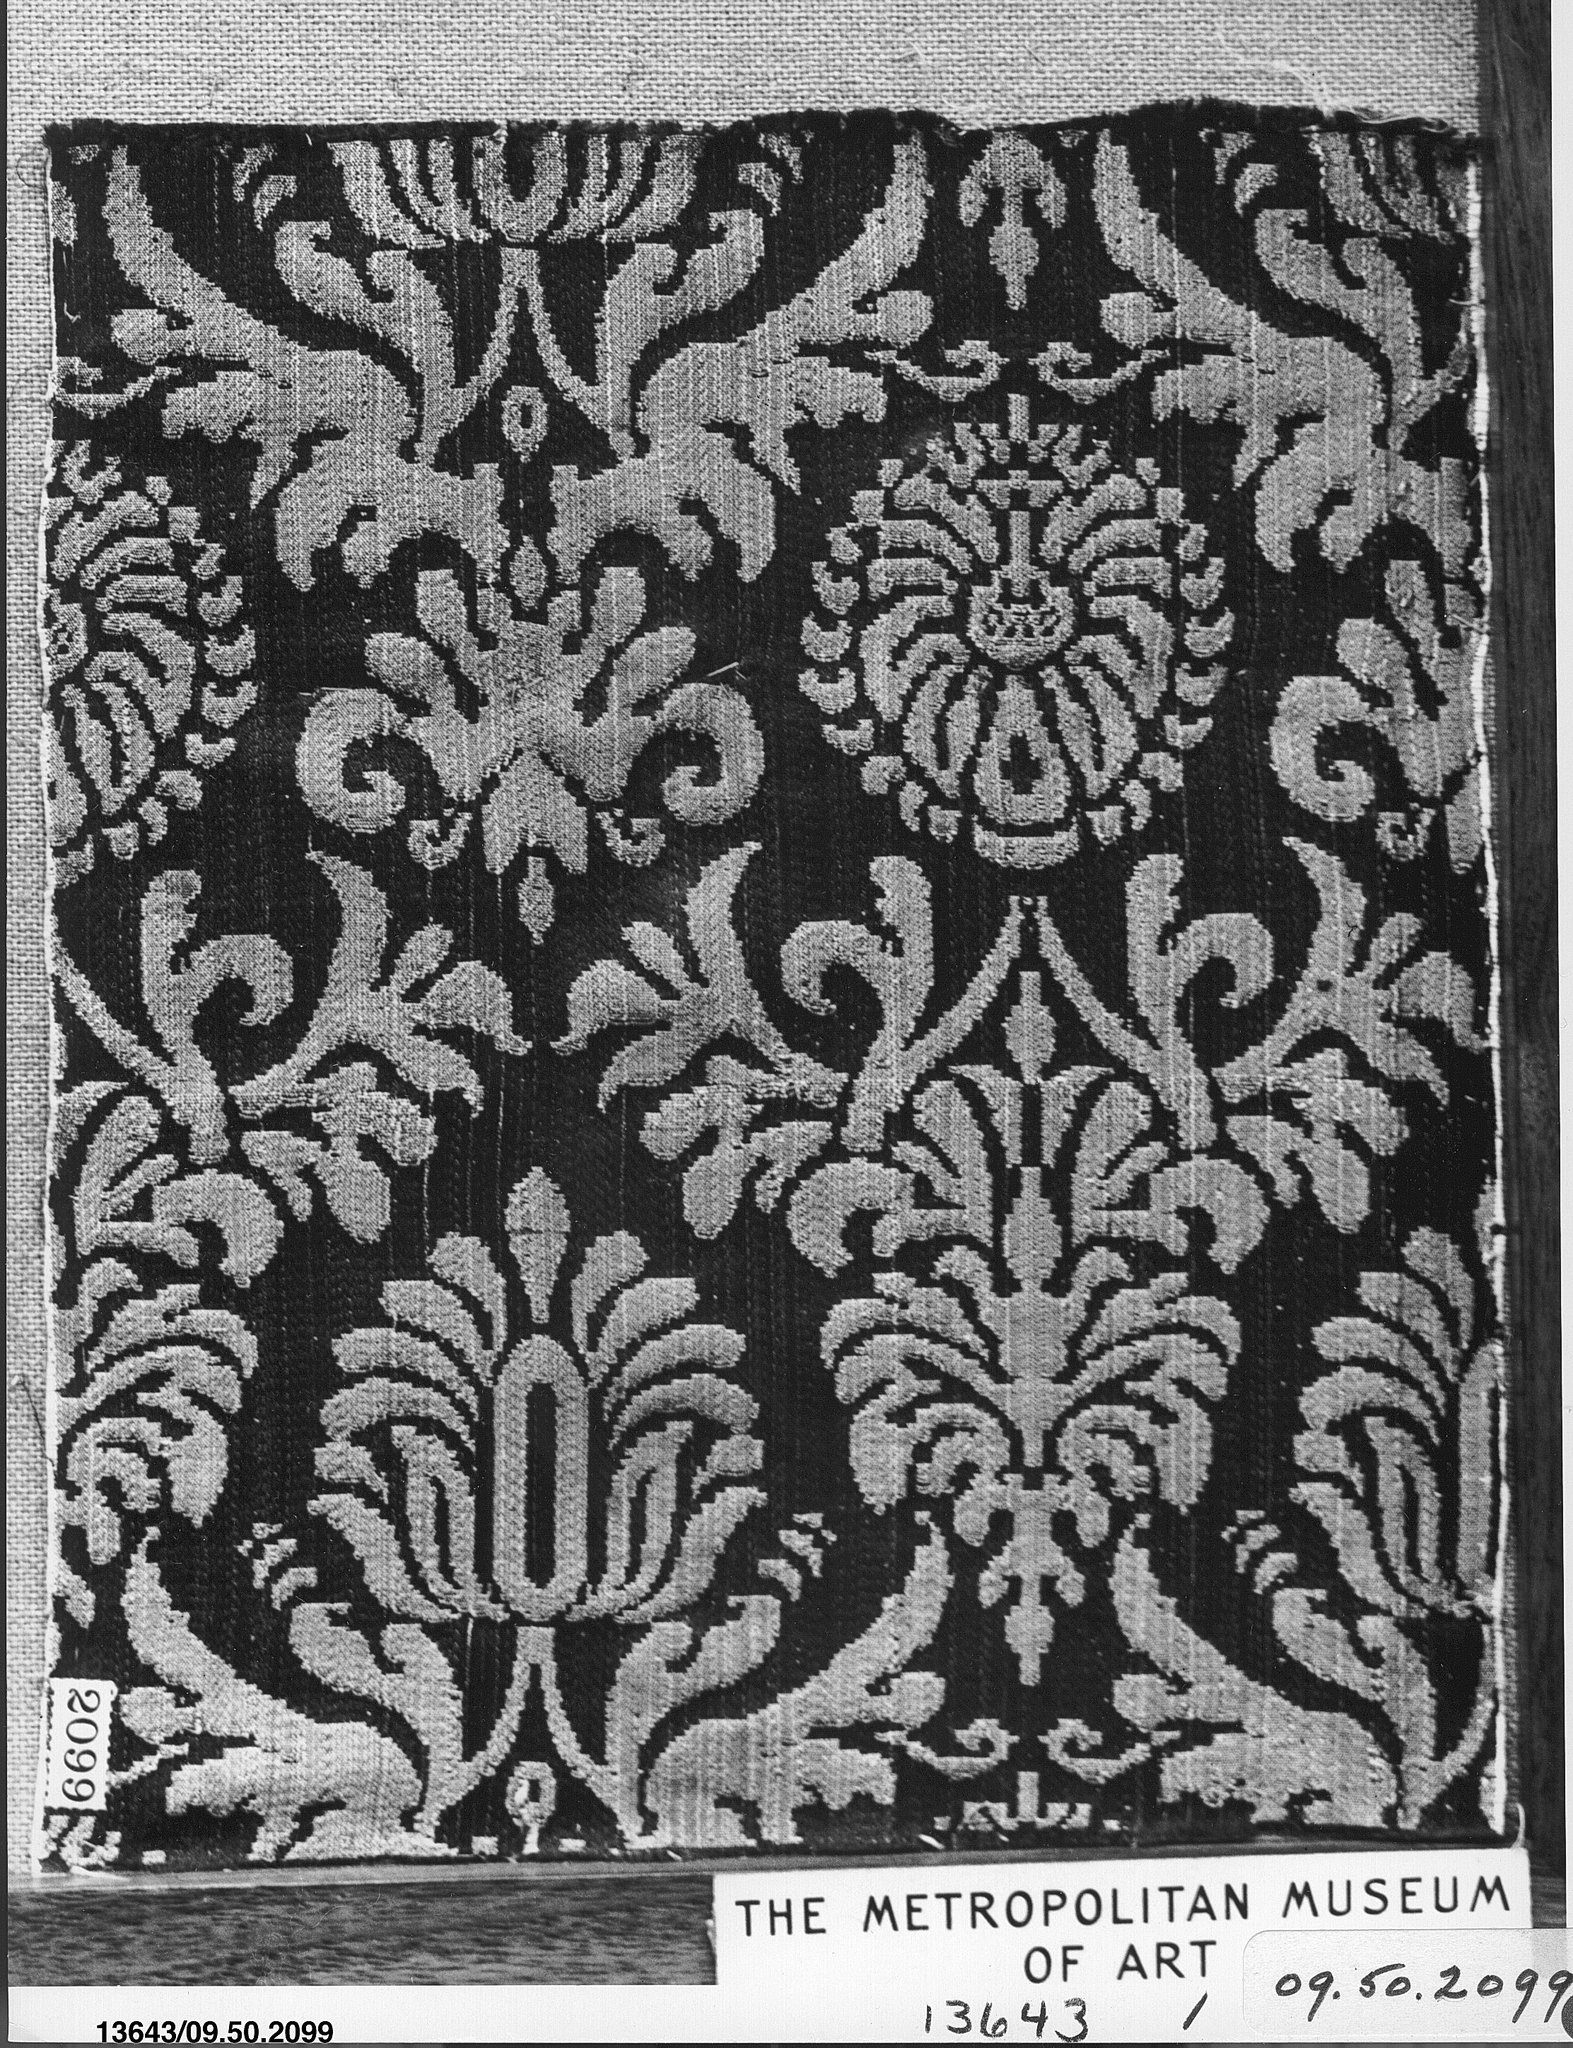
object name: piece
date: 1501-1600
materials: silk